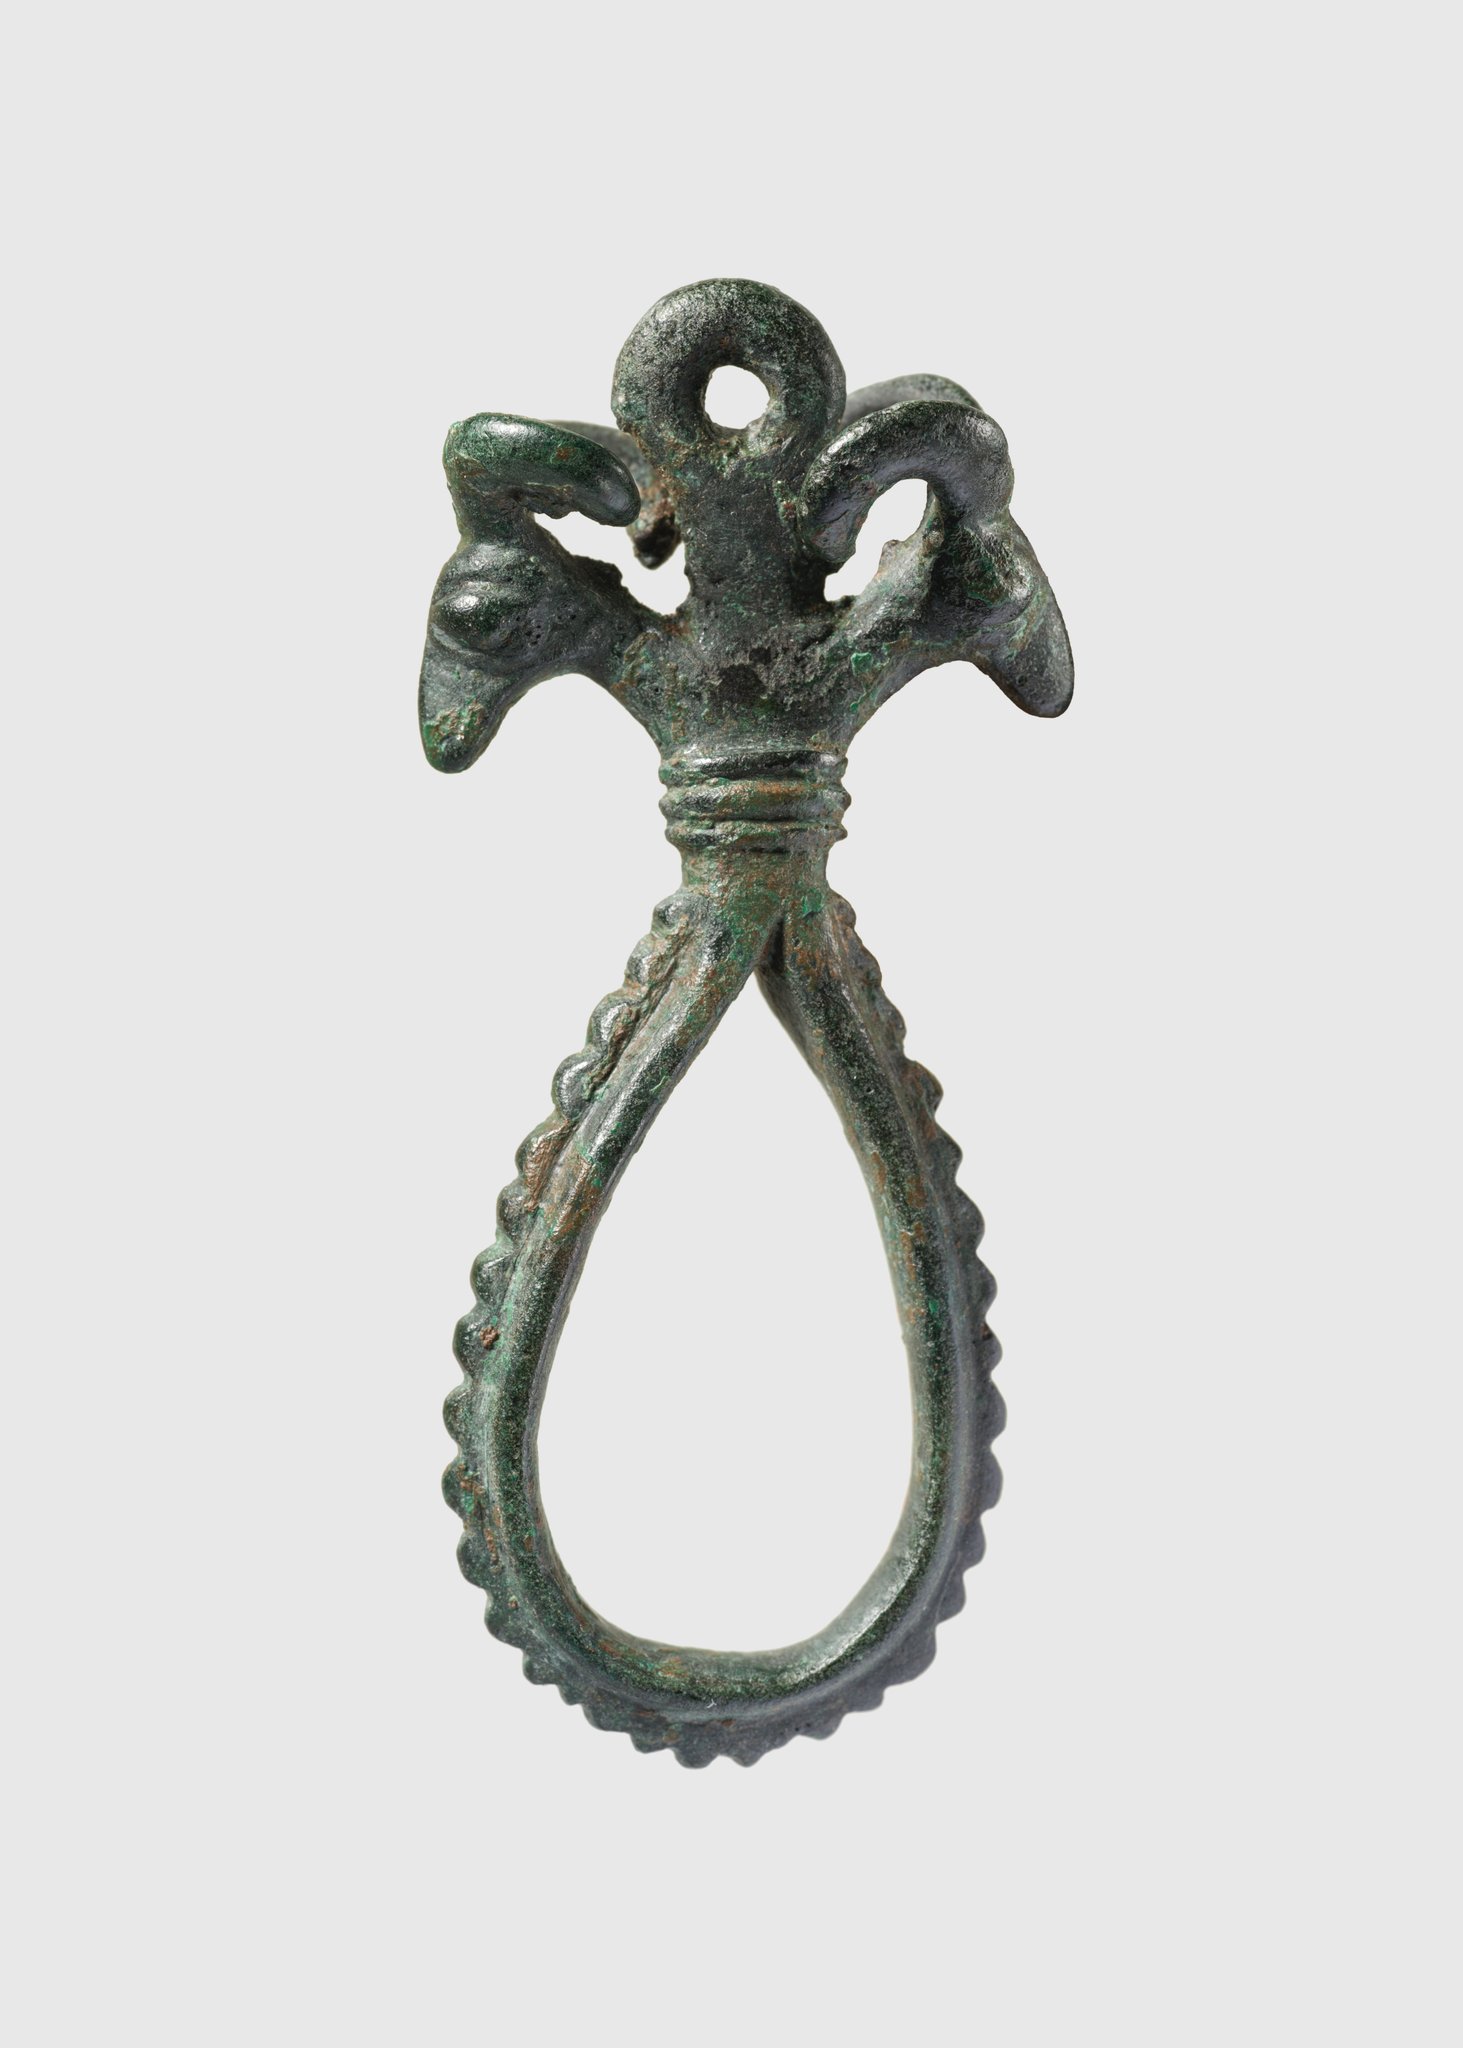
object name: pendant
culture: iranian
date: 800-601 BCE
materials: bronze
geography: iran, probably from luristan